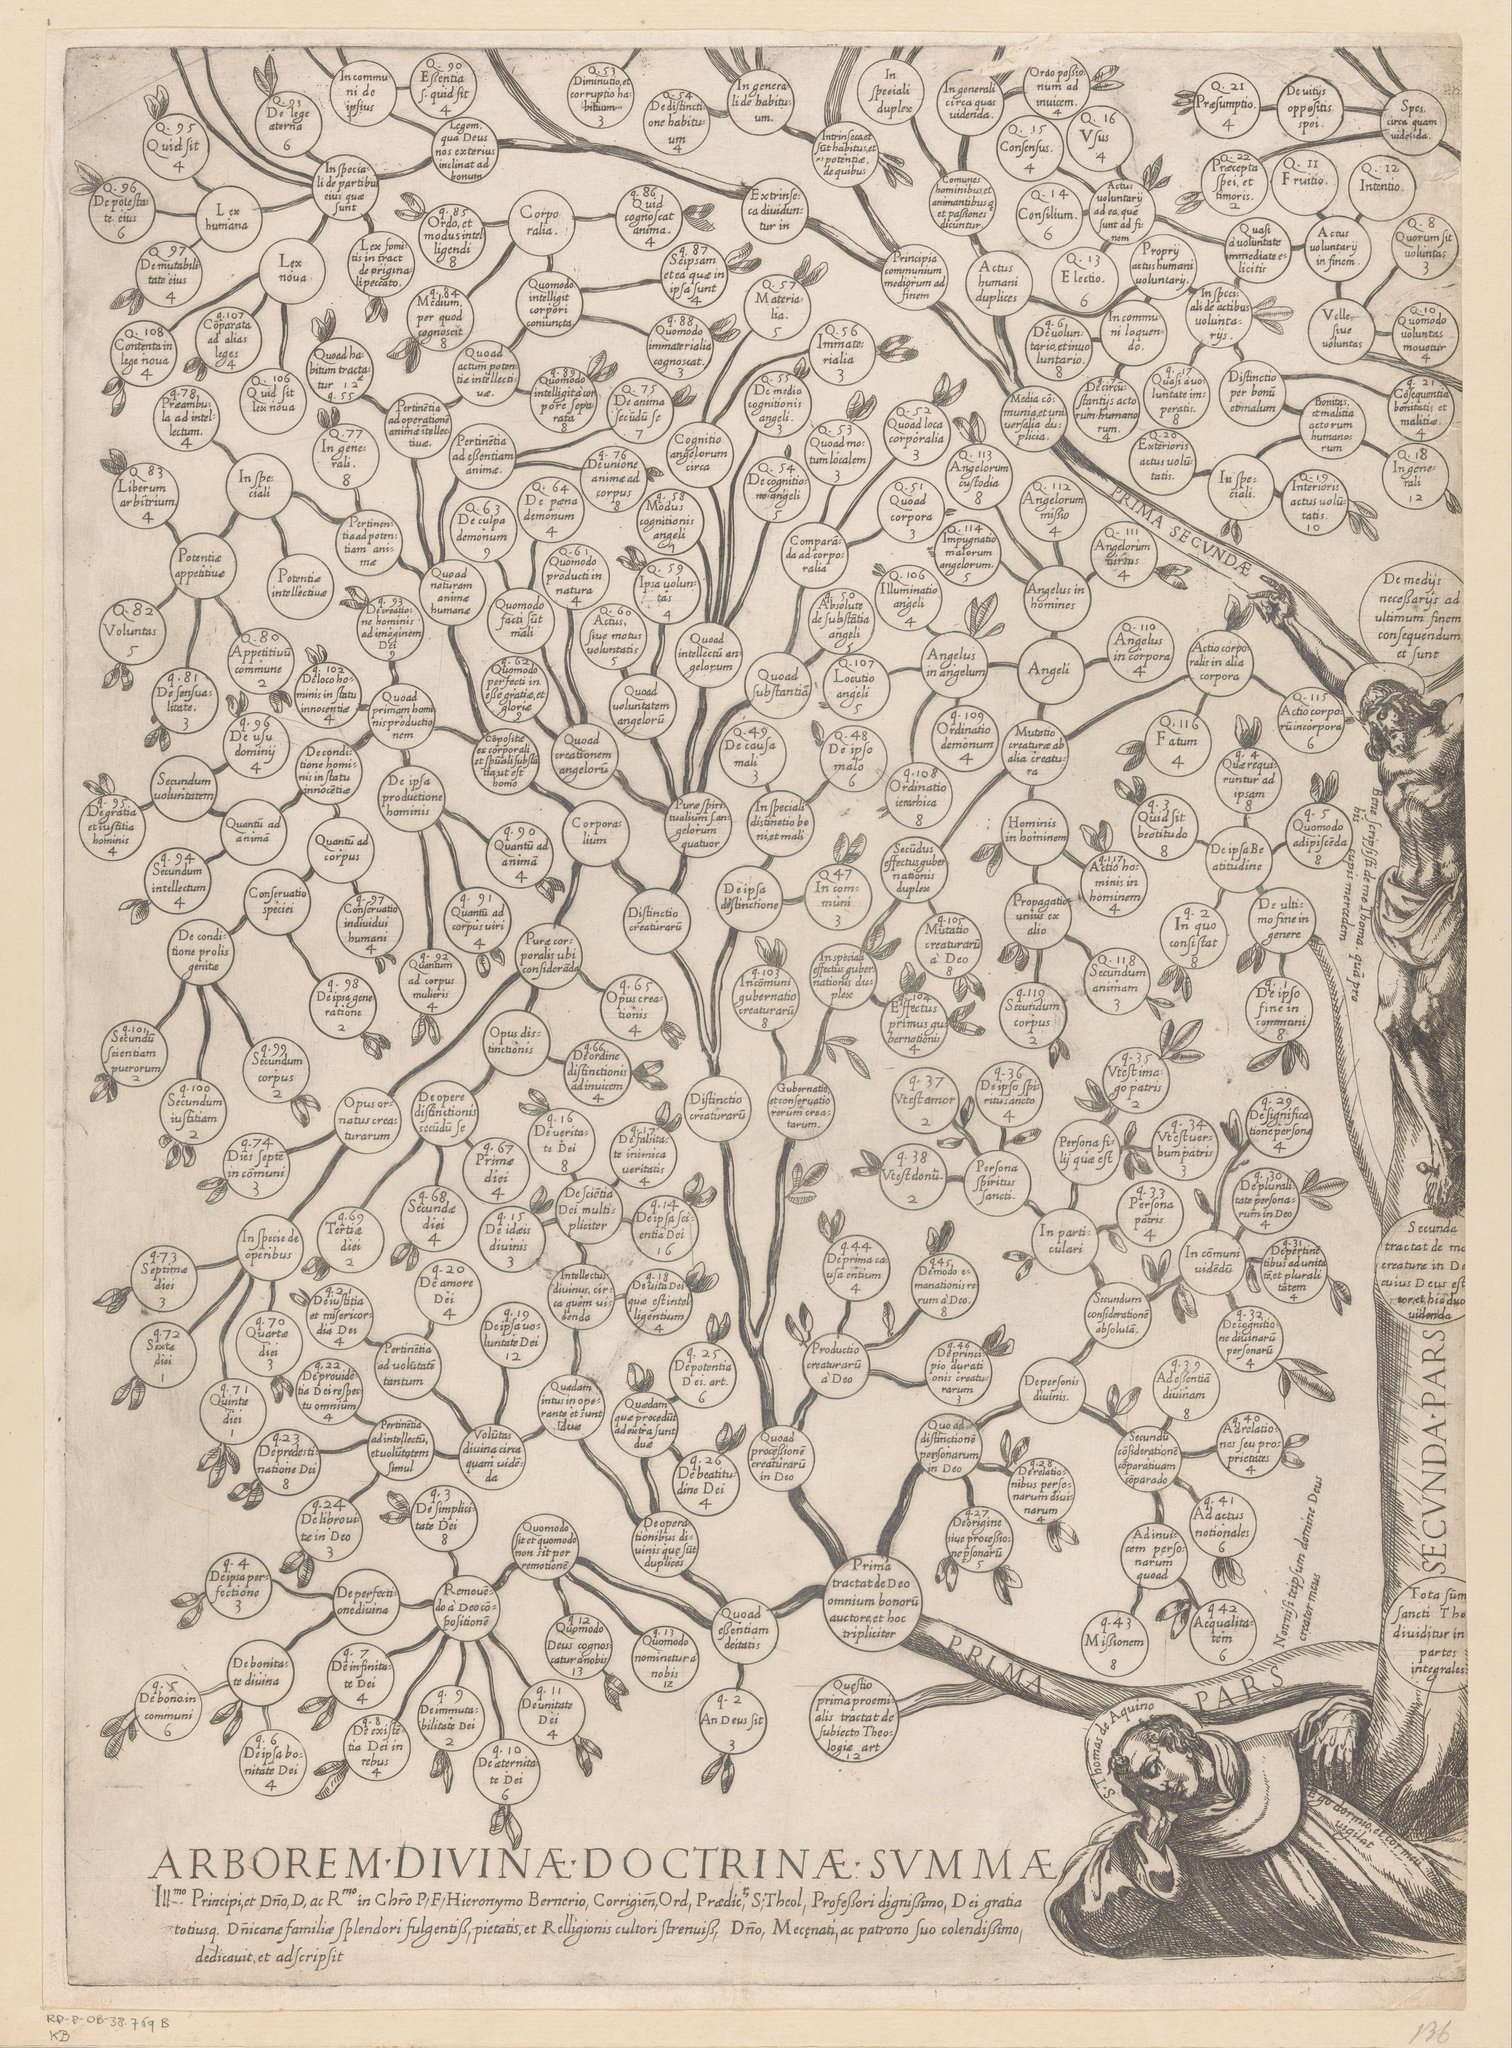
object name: print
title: Boom met Thomas van Aquino (deel linksonder)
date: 1590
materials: paper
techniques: etching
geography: rome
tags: thomas van aquino, christ crucified on a tree or on a vine, christian doctrine, the dominican theologian, 'angelic doctor' thomas of aquino; possible attributes: book, (chain with) sun, dove, girdle of chastity, lily, model of church, monstrance (or chalice), mitre (under feet), star (on breast)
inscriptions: collector's mark: Lugt 240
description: De filosoof en theoloog Thomas van Aquino ligt onderaan een boom. Op de stam van de boom de gekruisigde Christus. De vertakkingen van de boom representeren de drie delen van Aquino's 'Summa Theologiae'. Bovenaan in het midden God de Vader en de Heilige Geest als duif. Linksboven en rechtsboven een wapenschild.